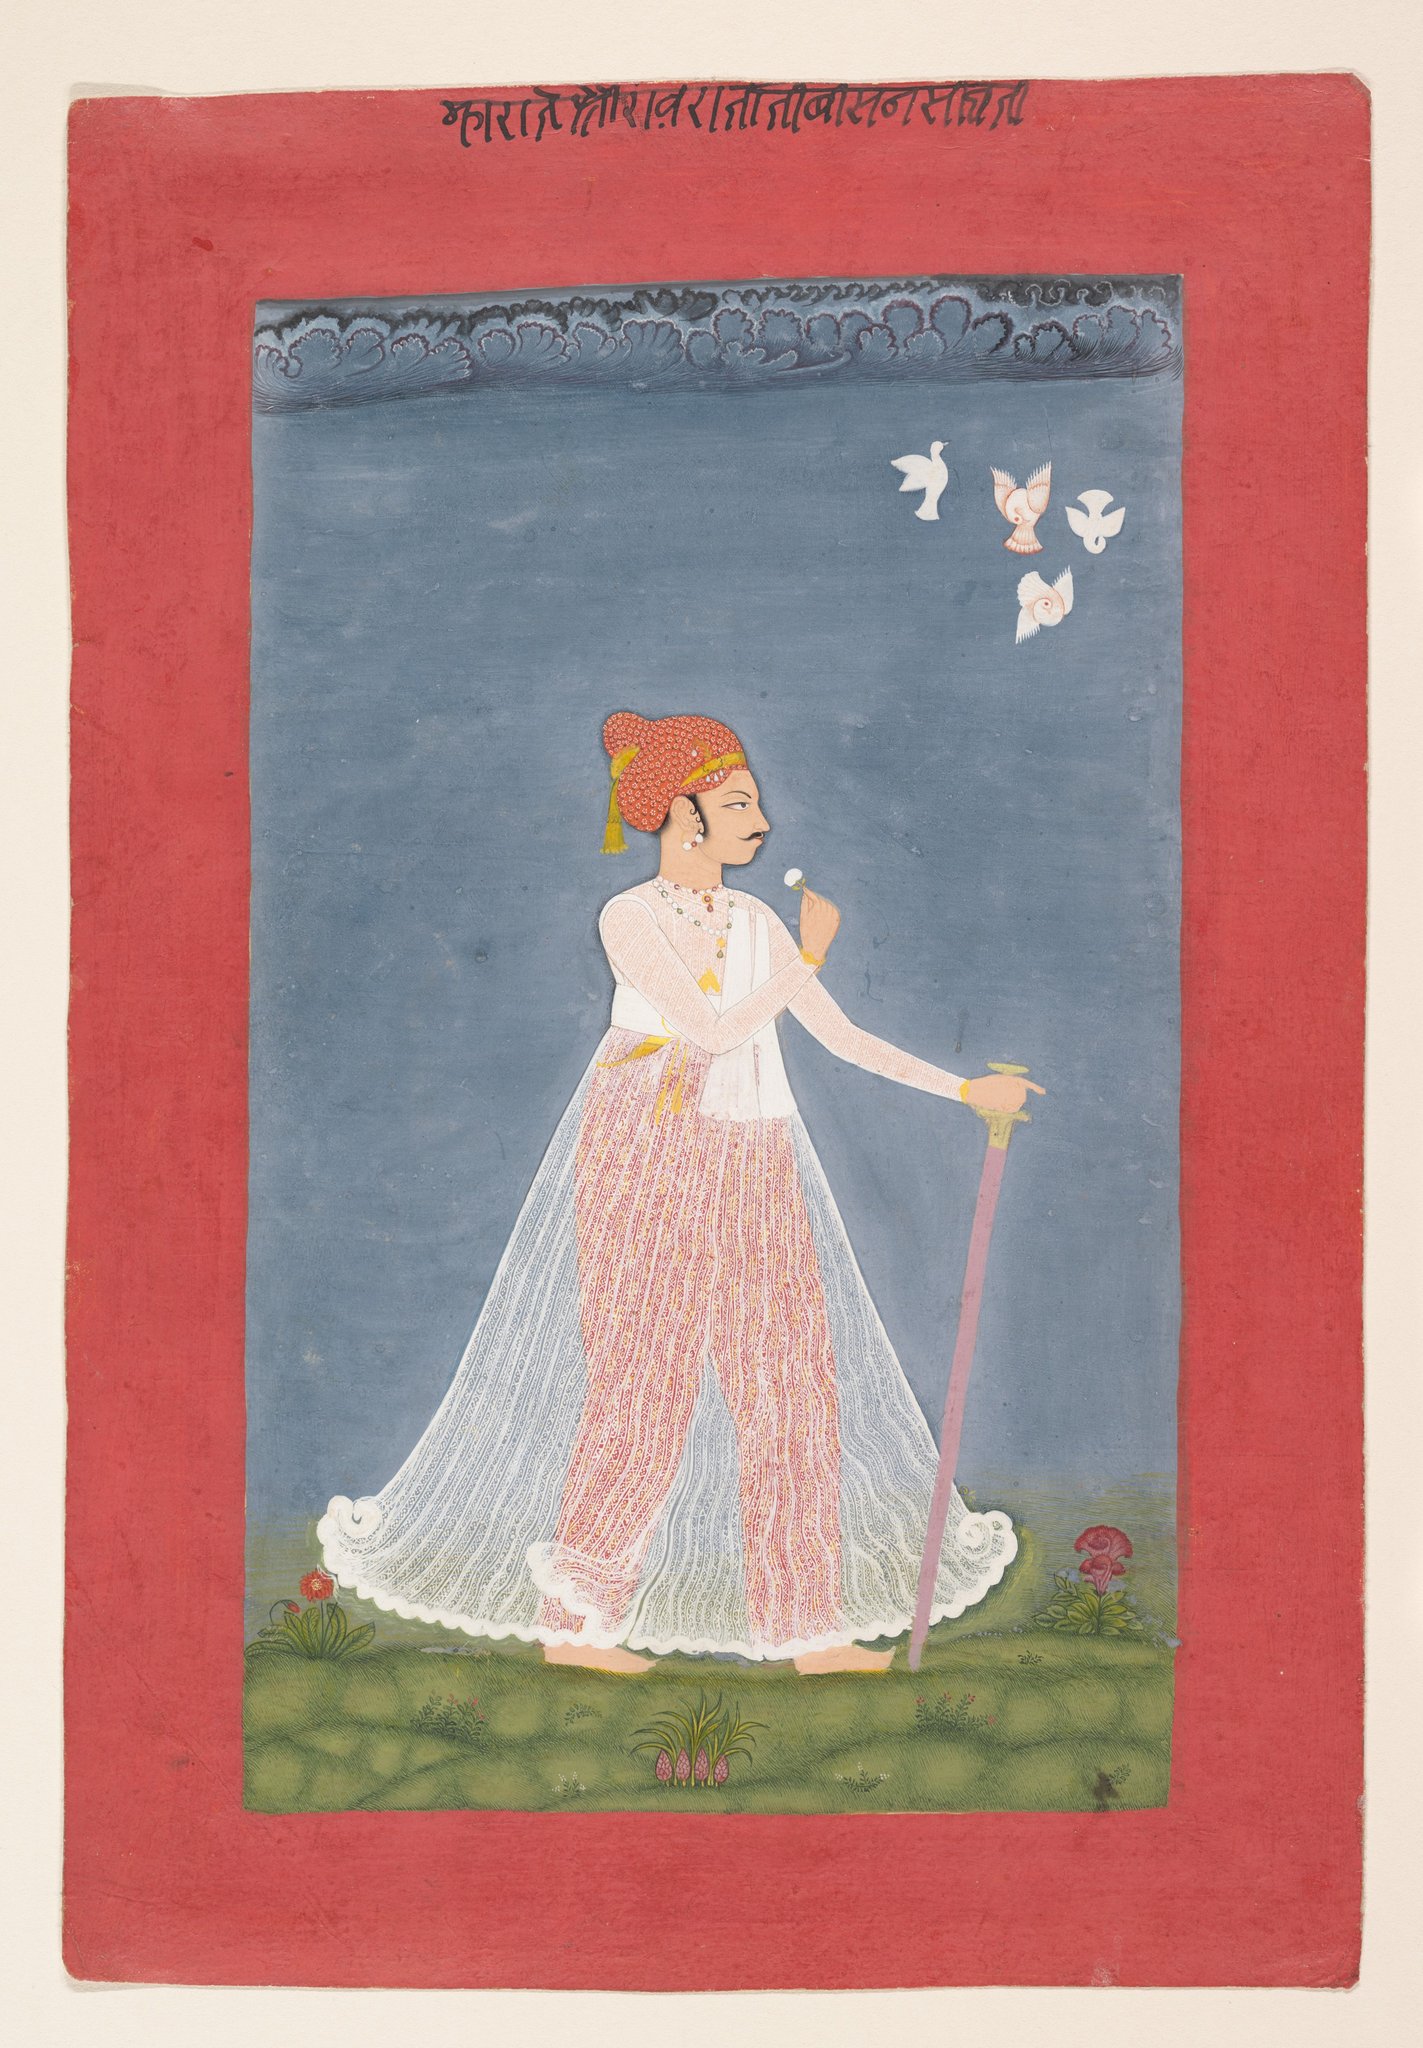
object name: painting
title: Bishen Singh as a Young Man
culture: indian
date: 1780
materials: ink, paper, watercolor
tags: princes,men